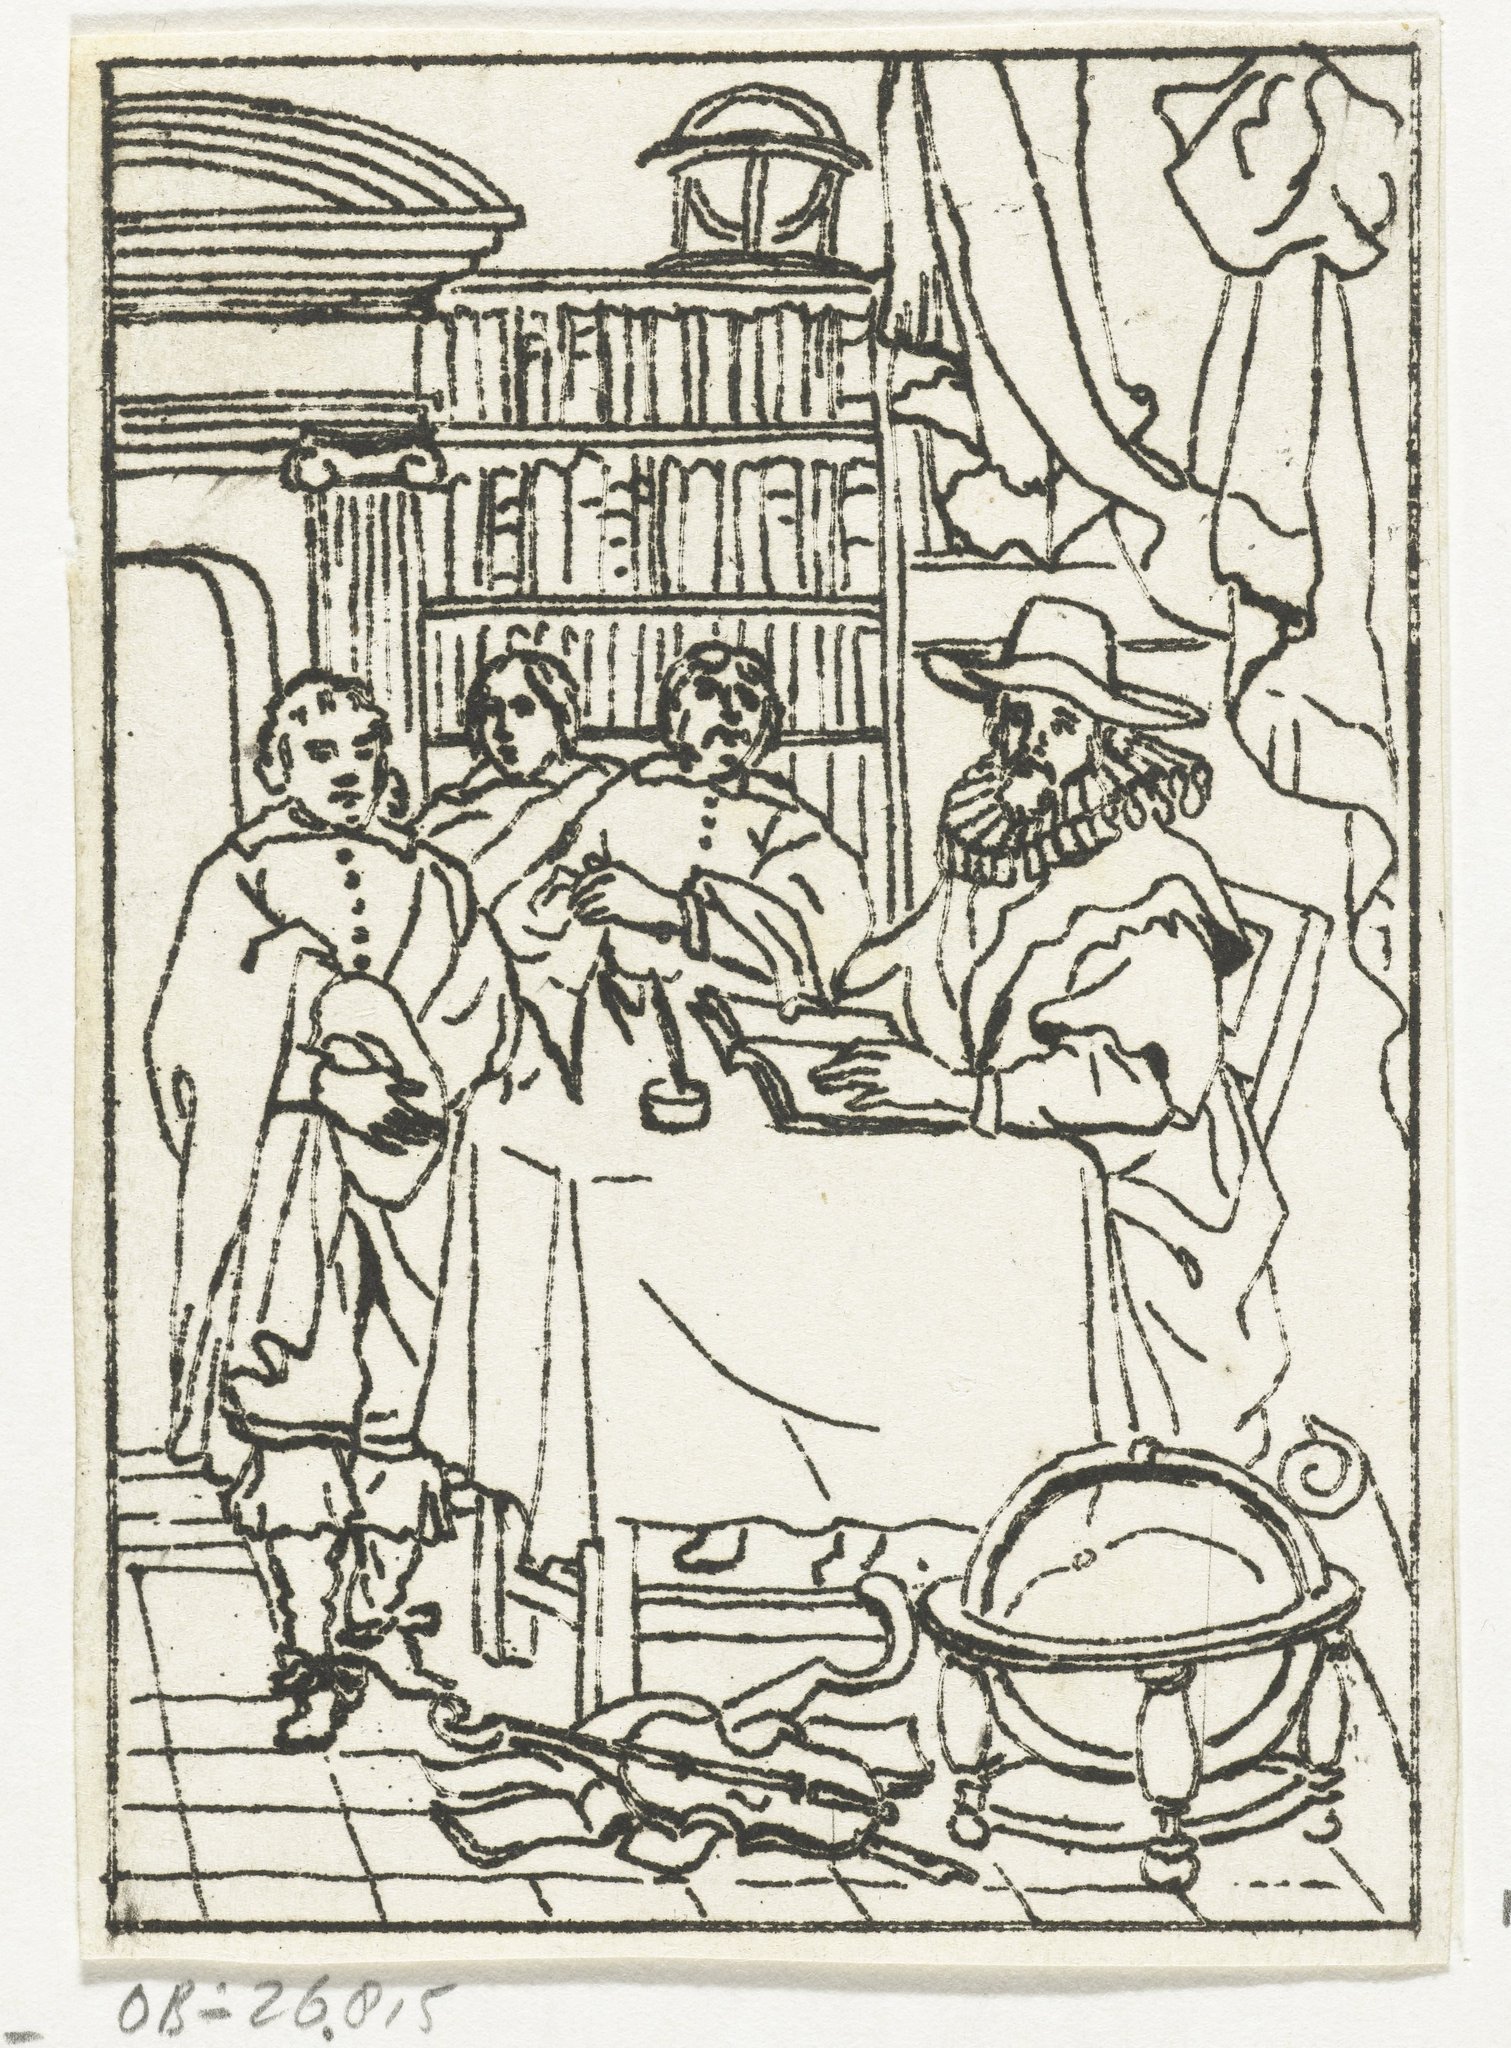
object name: print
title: Geleerde in studeervertrek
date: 1778-1838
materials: paper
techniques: etching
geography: netherlands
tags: scholar in his study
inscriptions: collector's mark: Lugt 2228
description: Een geleerde zit achter een schrijftafel in zijn studeervertrek en ontvangt drie mannen. Op de grond naast de tafel staat een globe en er ligt een viool. Tegen de muur staat een boekenkast. Op de kast staat een tweede globe.